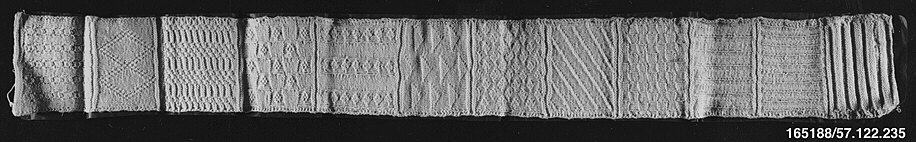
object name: sampler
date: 1801-1900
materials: wool